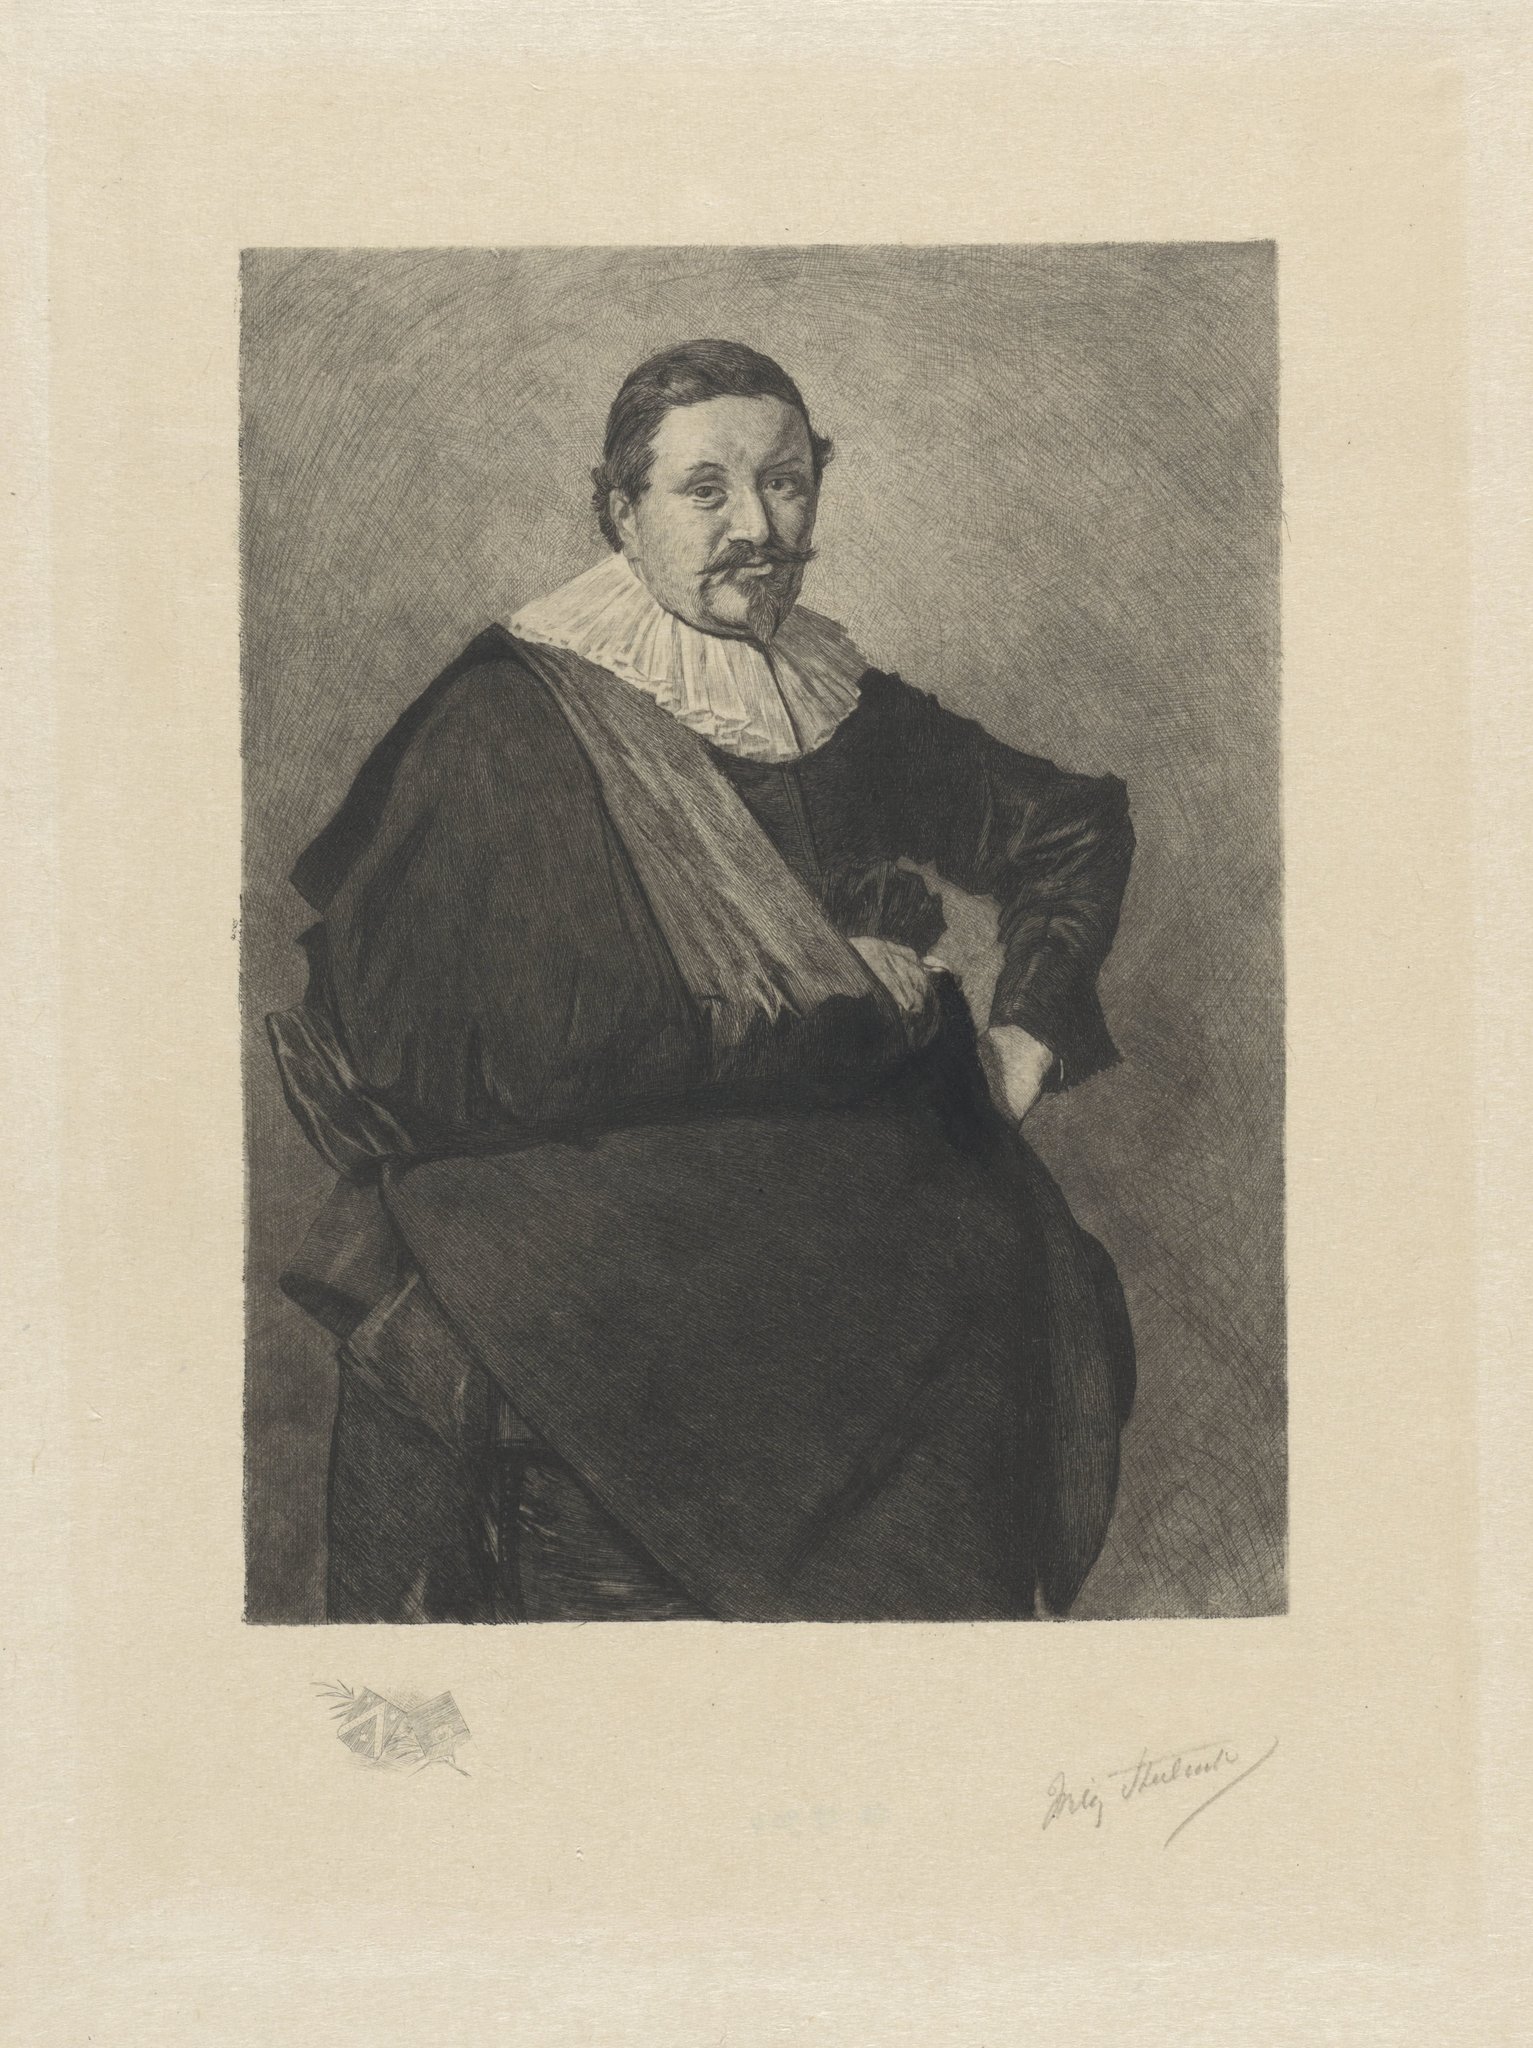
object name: print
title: Portret van Lucas de Clercq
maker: willem steelink (ii)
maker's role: draughtsman, print maker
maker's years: 1856-1928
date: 1888-1891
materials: paper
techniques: etching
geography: netherlands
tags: haarlem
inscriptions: collector's mark: Lugt 2228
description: Portret van Lucas de Clercq, handelaar in potas te Haarlem. Linksonder in de marge twee wapenschilden op een takje met bladeren.